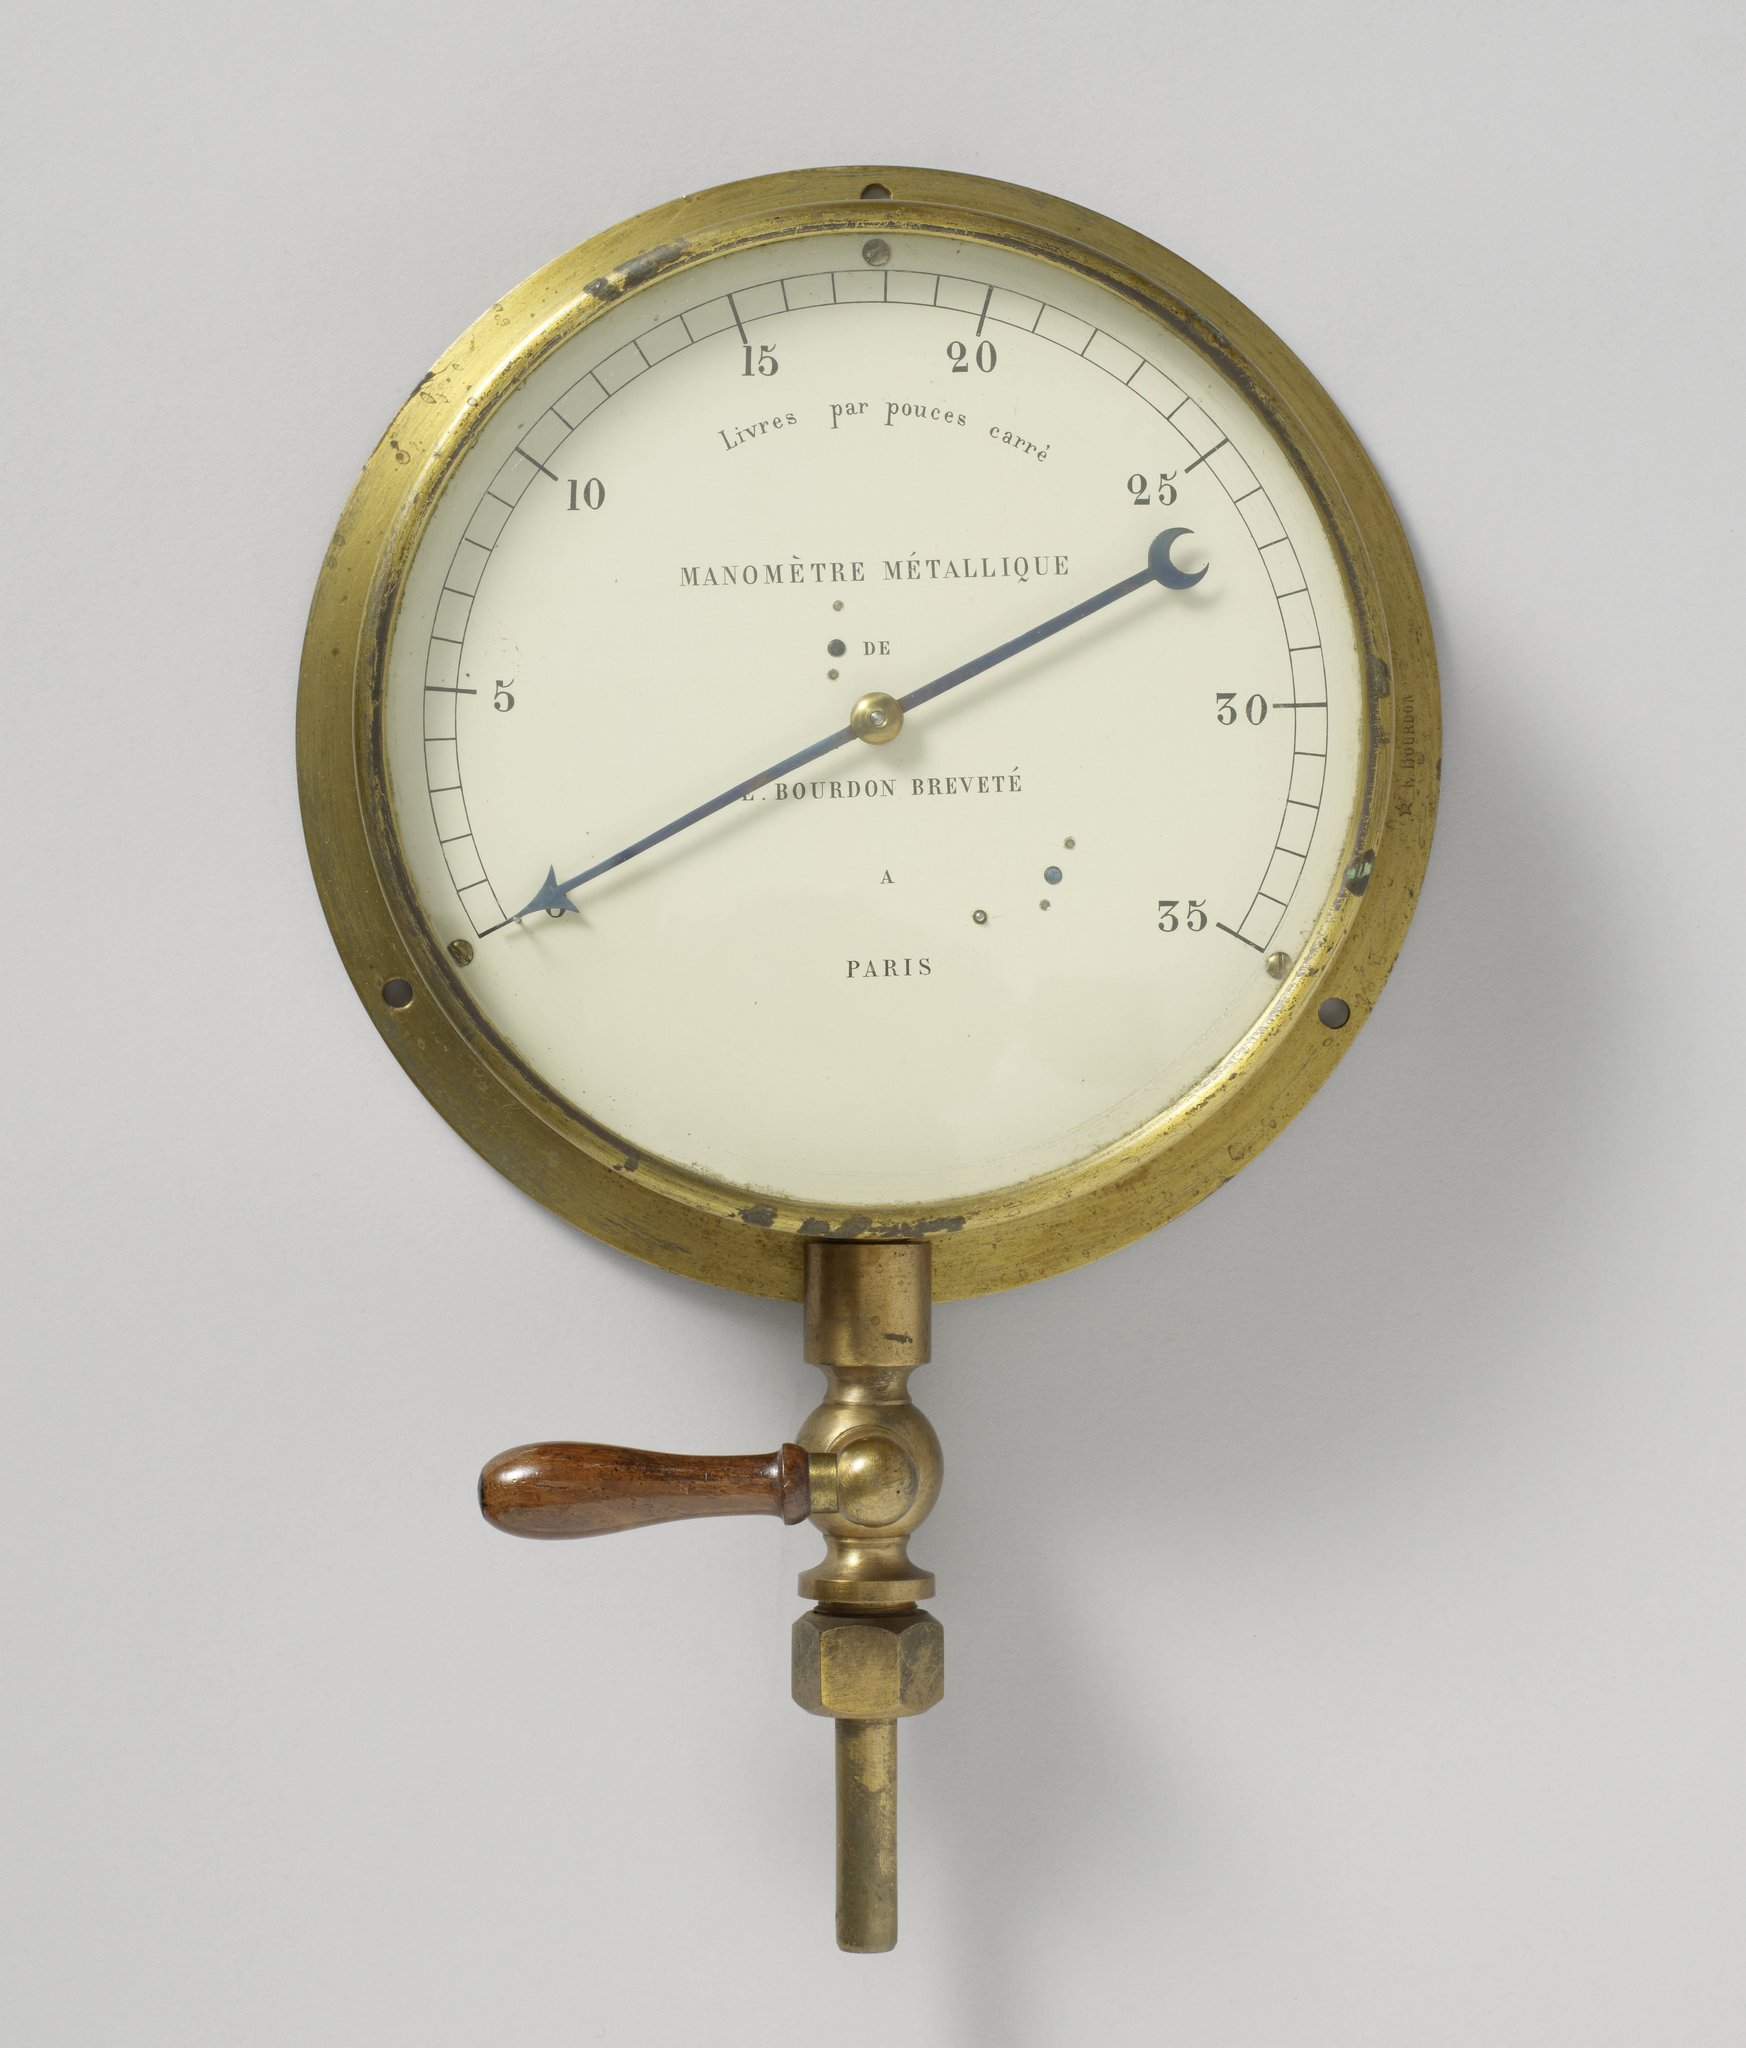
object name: barometer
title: Aneroid Barometer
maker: eugène bourdon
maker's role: clockmaker, instrument maker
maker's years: 1808-1884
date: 1860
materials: brass, copper, glass, iron, steel, wood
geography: paris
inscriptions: inscription, on the dial: ‘Livres par pouce carré / MANOMETRE METALLIQUE / DE / E. BOURDON BREVETE / A / PARIS E. BOURDON 1667’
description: Metaalbarometer bestaande uit een ronde wijzerplaat gemonteerd op een kraan. De wijzerplaat heeft een wijzer en een schaal lopende van nul tot vijf en dertig. Het mechanisme binnenin bestaat uit een platte buis, die langs de buitenkant van de behuizing is gebogen en krult of ontkrult op de druk, en een klein raderwerkje dat de beweging van de buis op de wijzer overbrengt.